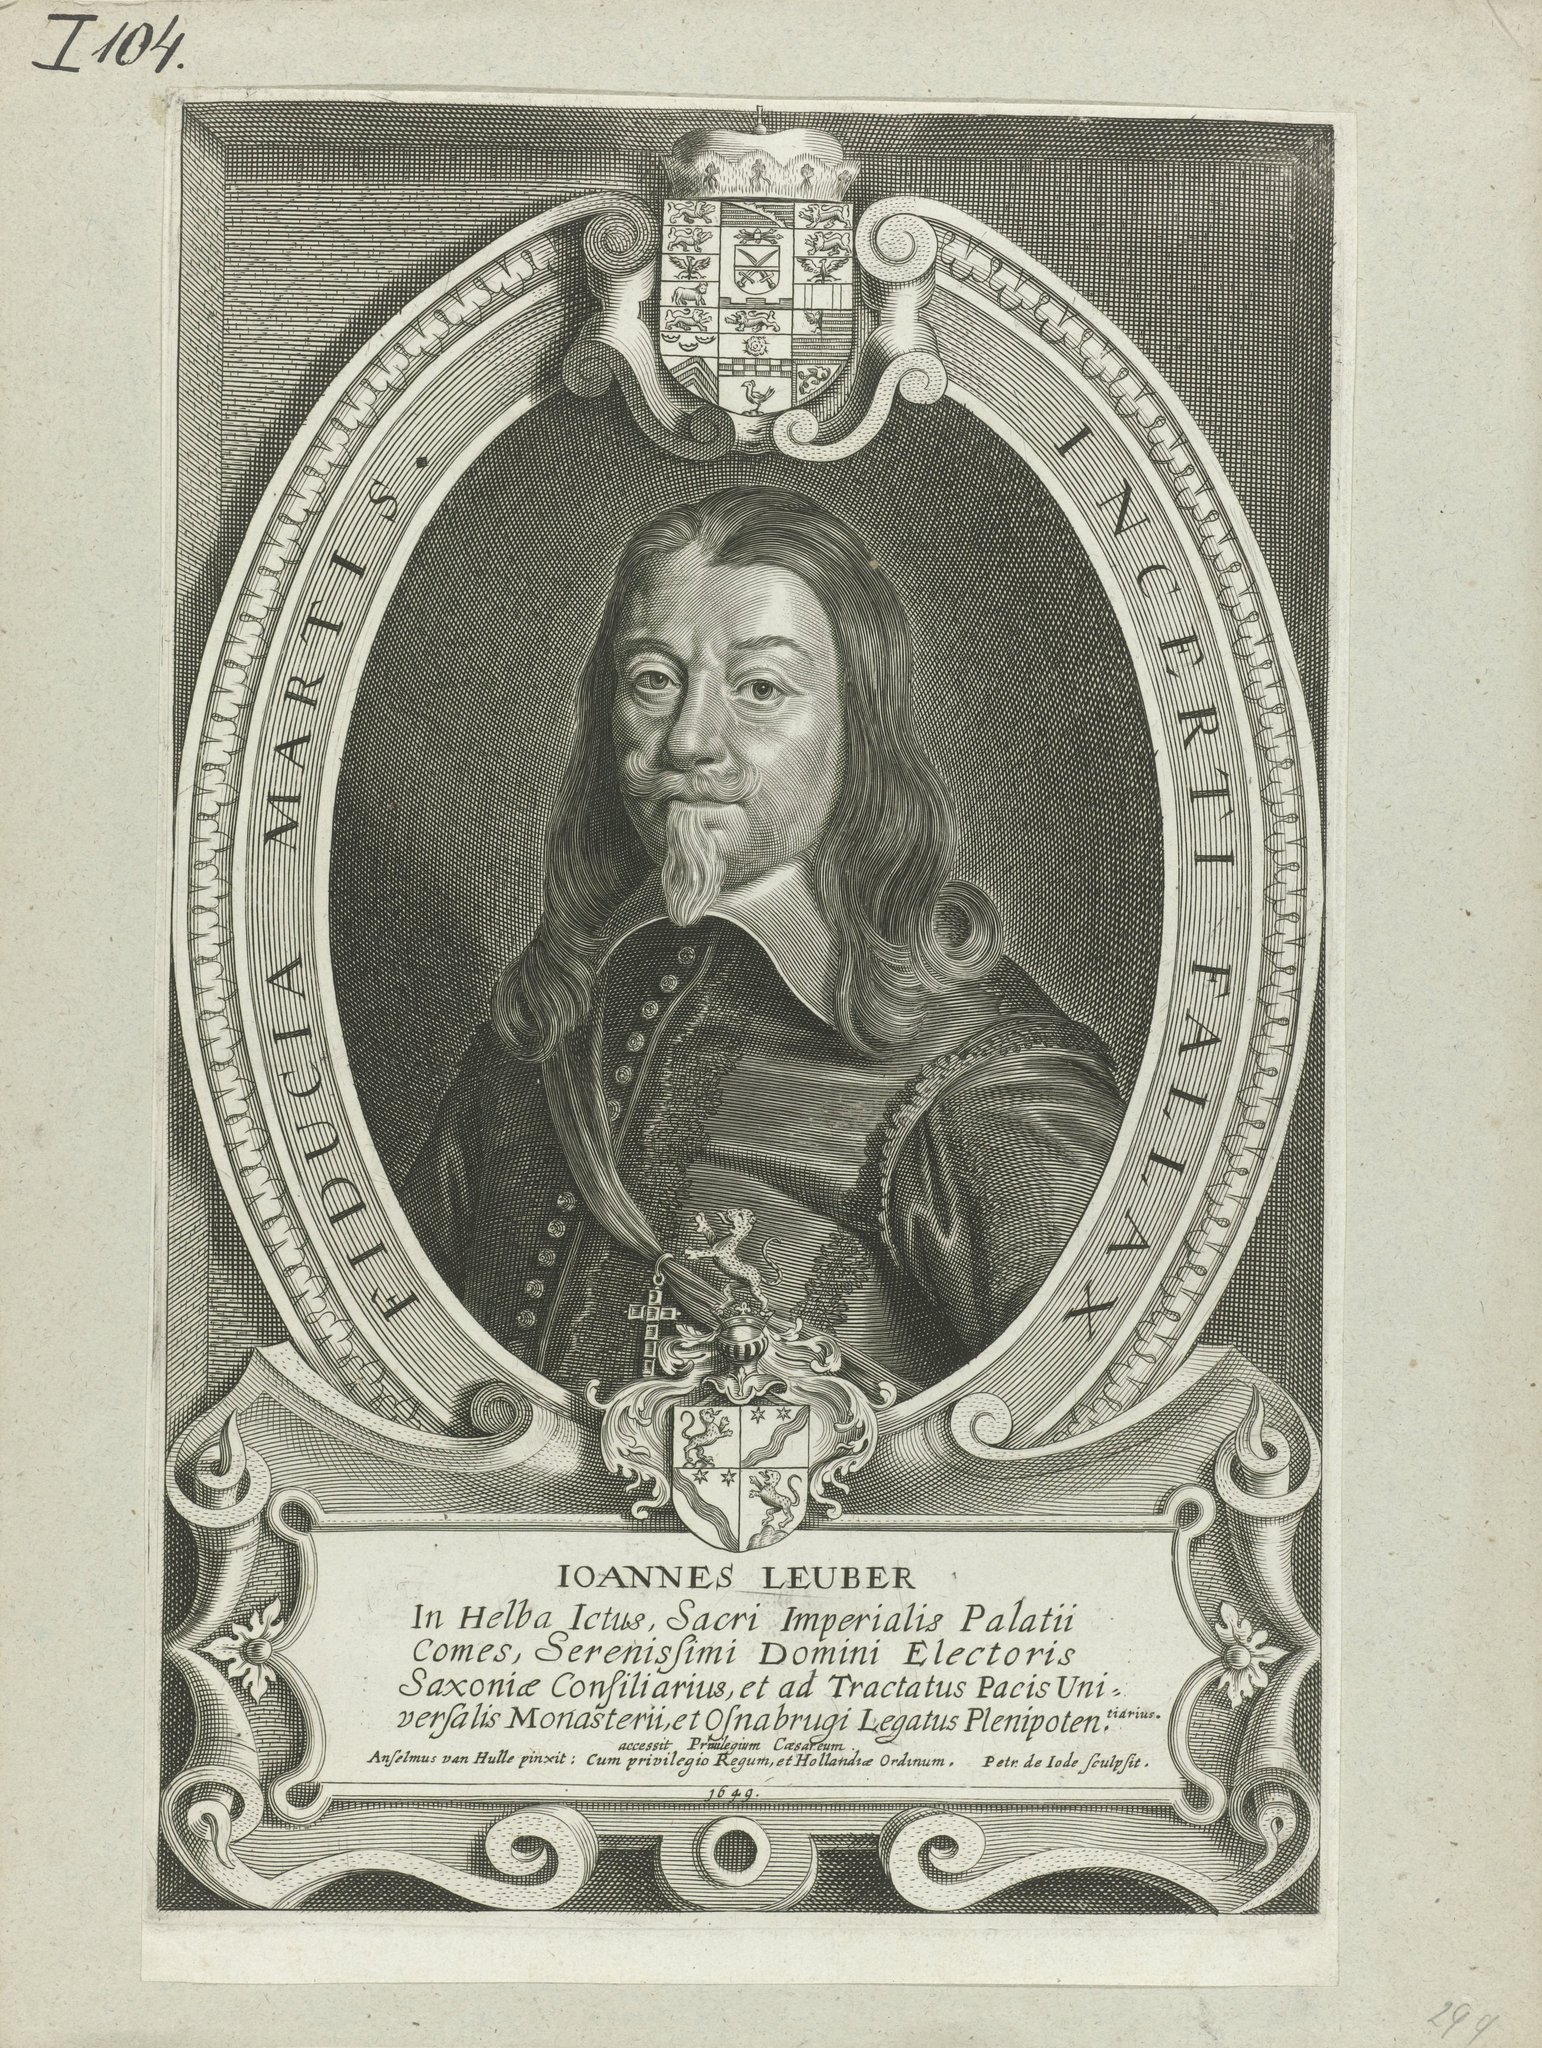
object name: print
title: Celeberrimi Legati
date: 1649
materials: paper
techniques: engraving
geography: antwerp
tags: thüringen, dresden, staatsman, johann leuber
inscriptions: collector's mark: Lugt 2228, collector's mark: Lugt 2760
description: Busteportret van Johann Leuber. Het portret is gevat in een ovale omlijsting met het wapenschild van de geportretteerde en een randschrift in het Latijn. In de cartouche een vijfregelig onderschrift in het Latijn. Prent uit een serie portretten naar schilderijen van Anselmus van Hulle van alle gedelegeerden bij de vredesonderhandelingen te Münster en Osnabrück.